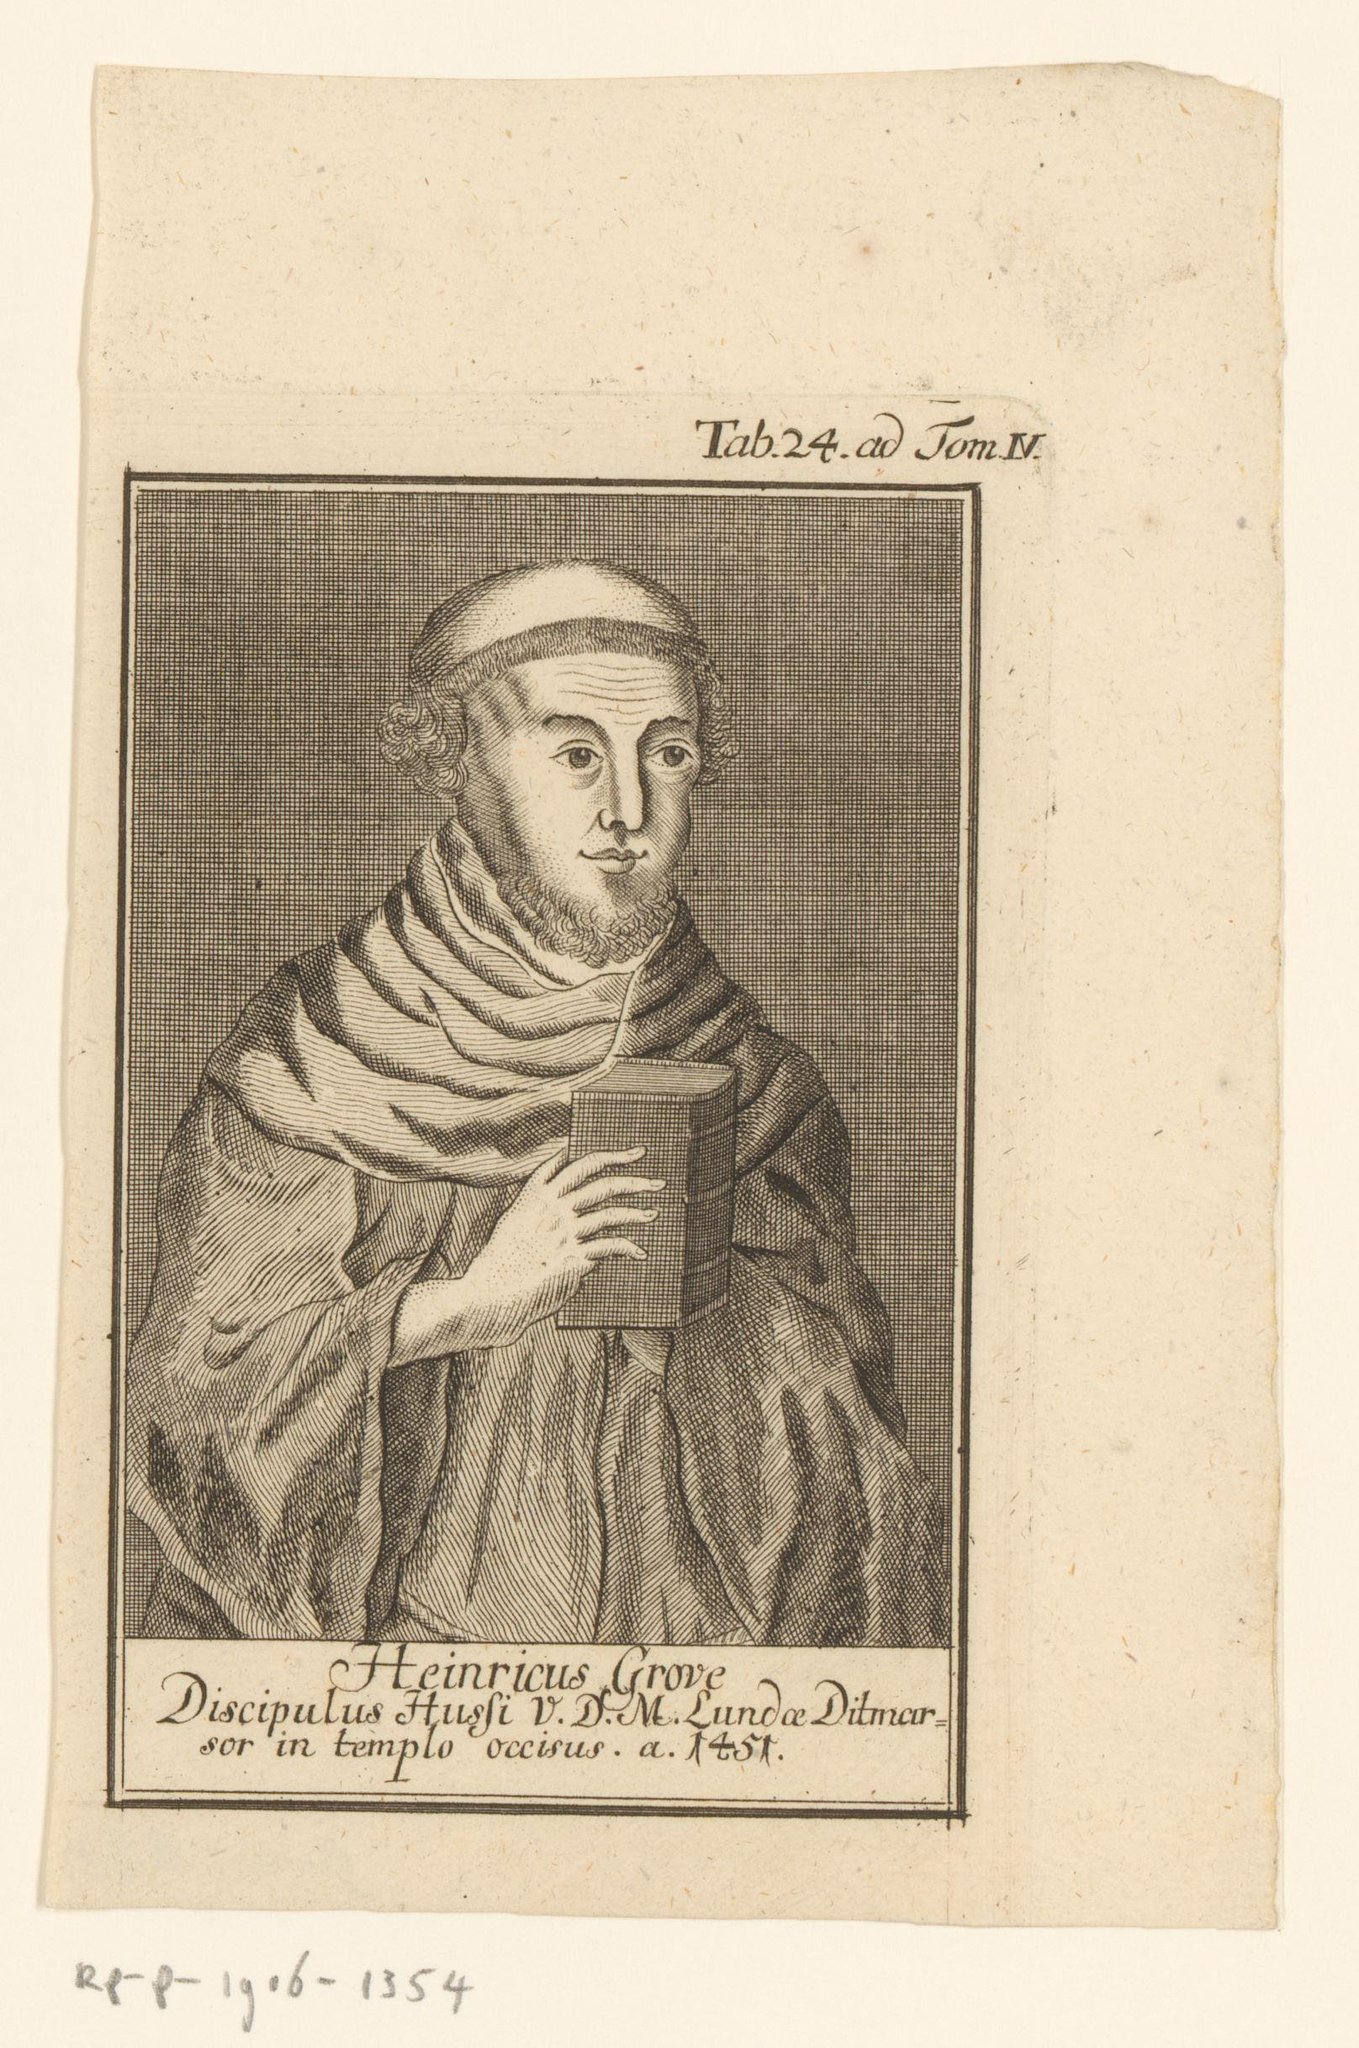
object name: print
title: Portret van Heinricus Grove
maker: johann christian püschel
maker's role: print maker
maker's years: 1718-1771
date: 1728-1771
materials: paper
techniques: engraving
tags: theologian, historical persons, book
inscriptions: collector's mark: Lugt 2228